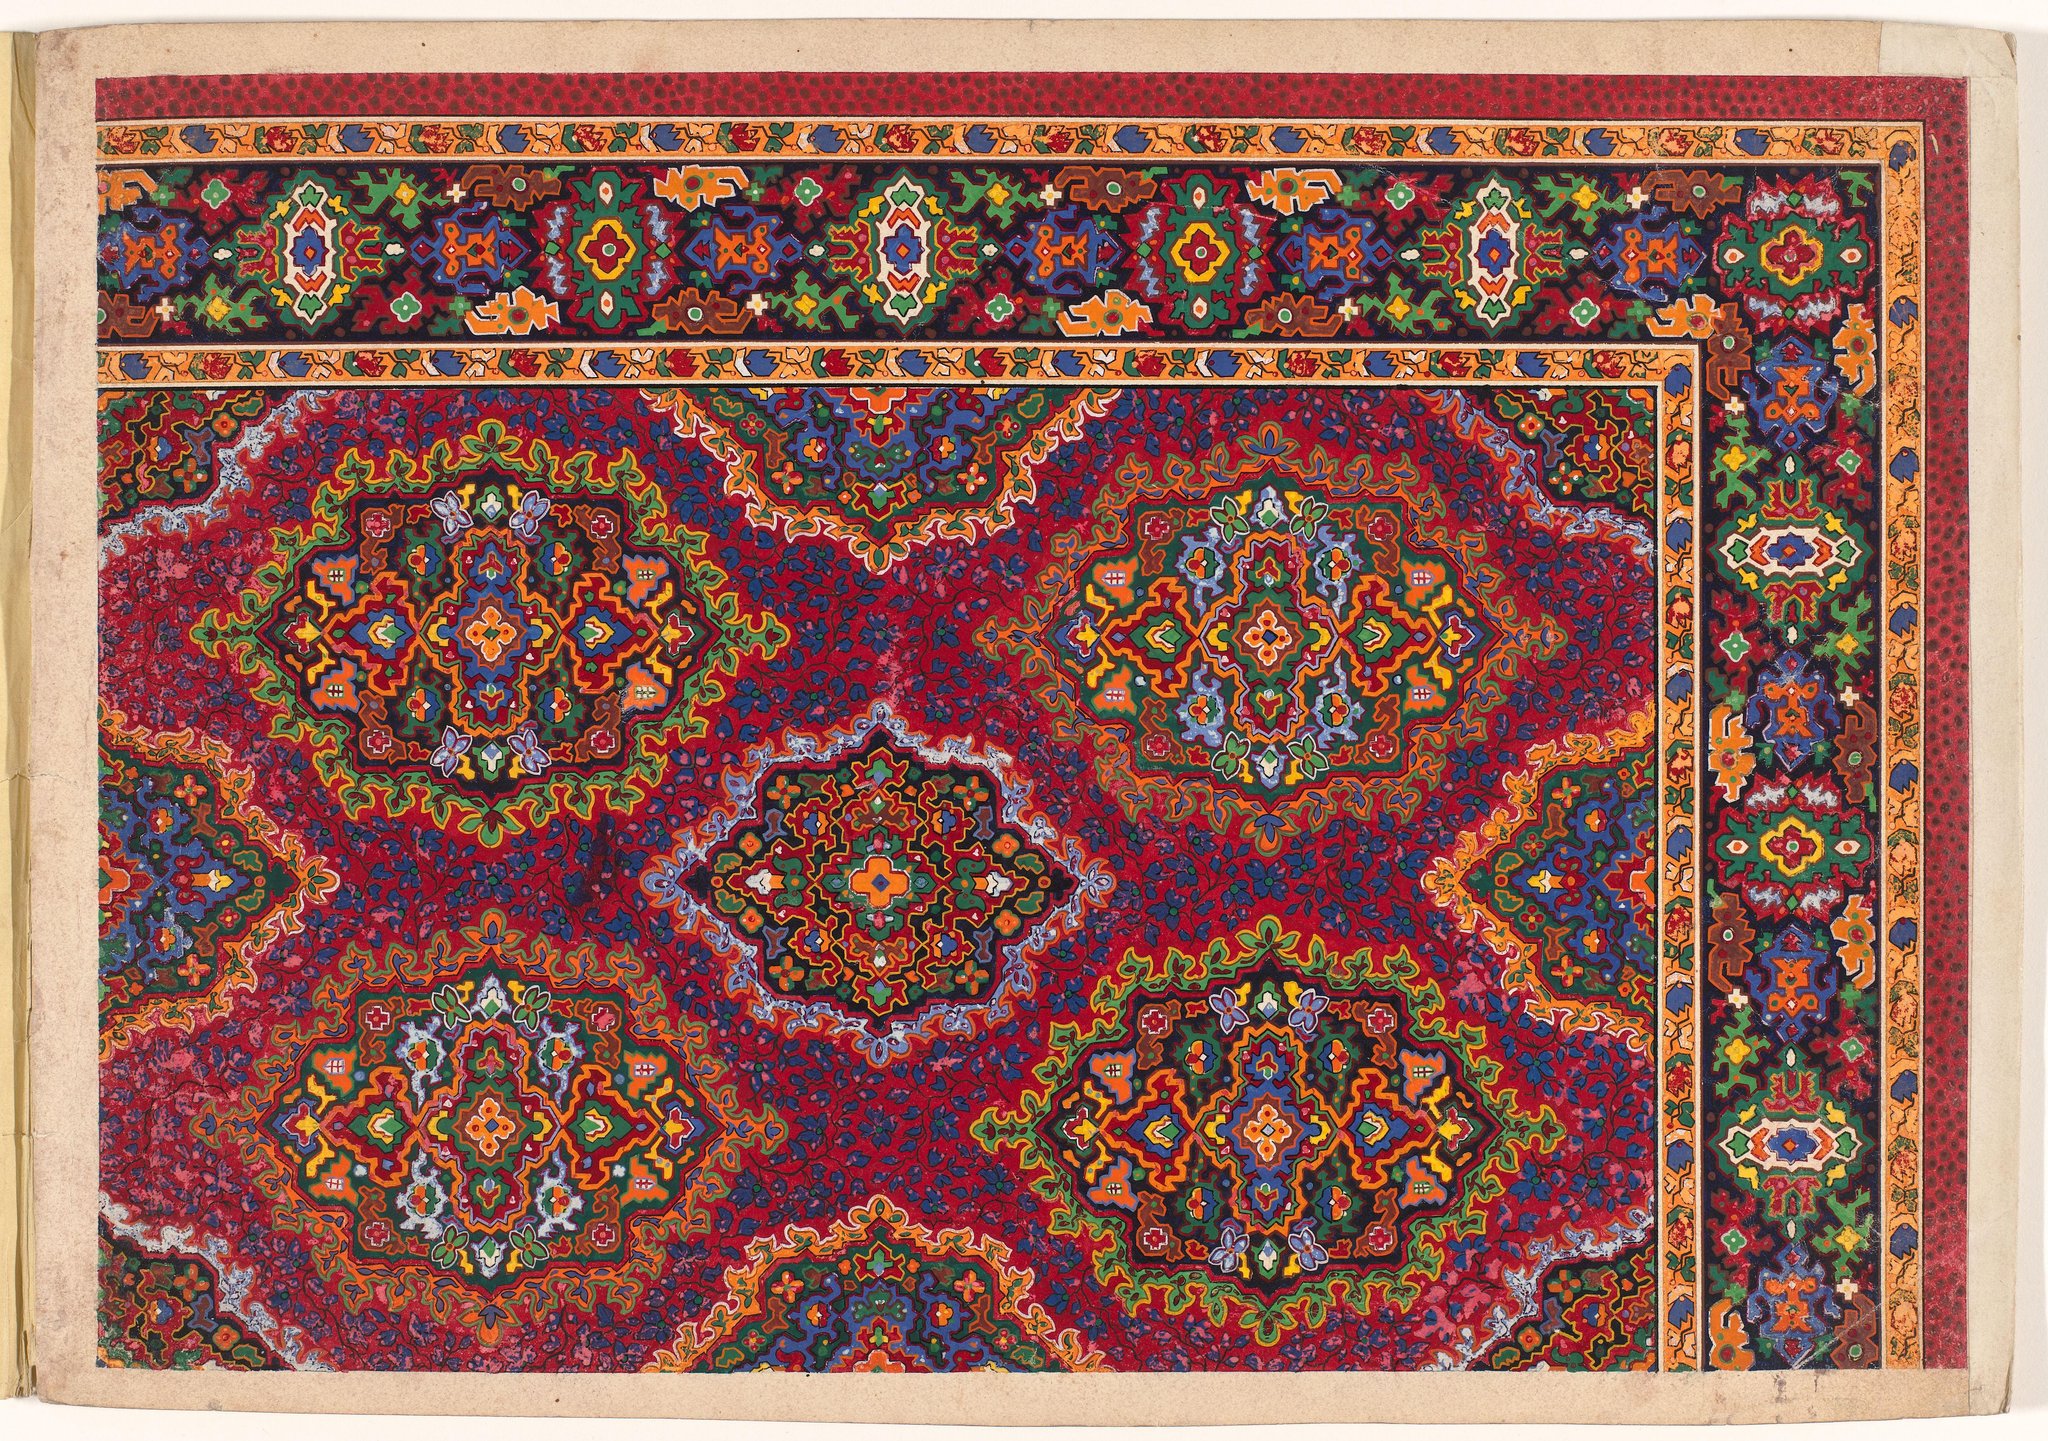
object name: drawing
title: Ontwerp voor een tapijt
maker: Anonymous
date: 1854-1864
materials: gouache, paper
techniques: brush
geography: deventer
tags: ornaments ~ art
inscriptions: number: ‘No 359 A.’, retailer's mark: ‘JHS.’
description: De presentatietekeningen BK-1971-77-1 t/m 86 zijn kopieën van de originele ontwerptekeningen. Ze werden gemaakt voor vertegenwoordigers van bijvoorbeeld magazijnen, die ze aan hun klanten konden tonen. De meeste tekeningen tonen een kwart van het dessin inclusief rand, middenpartij (de zogenaamde grond of fond) en centraal medaillon. Door het gebruik van spiegels kan de illusie van het gehele tapijt worden opgeroepen. Een deel van de tekeningen heeft een alfabetische opeenvolgende letter als kenmerk, de andere groep een cijfer.Waarschijnlijk is de reeks dessins met een letter eerder samengesteld dan de genummerde tekeningen.